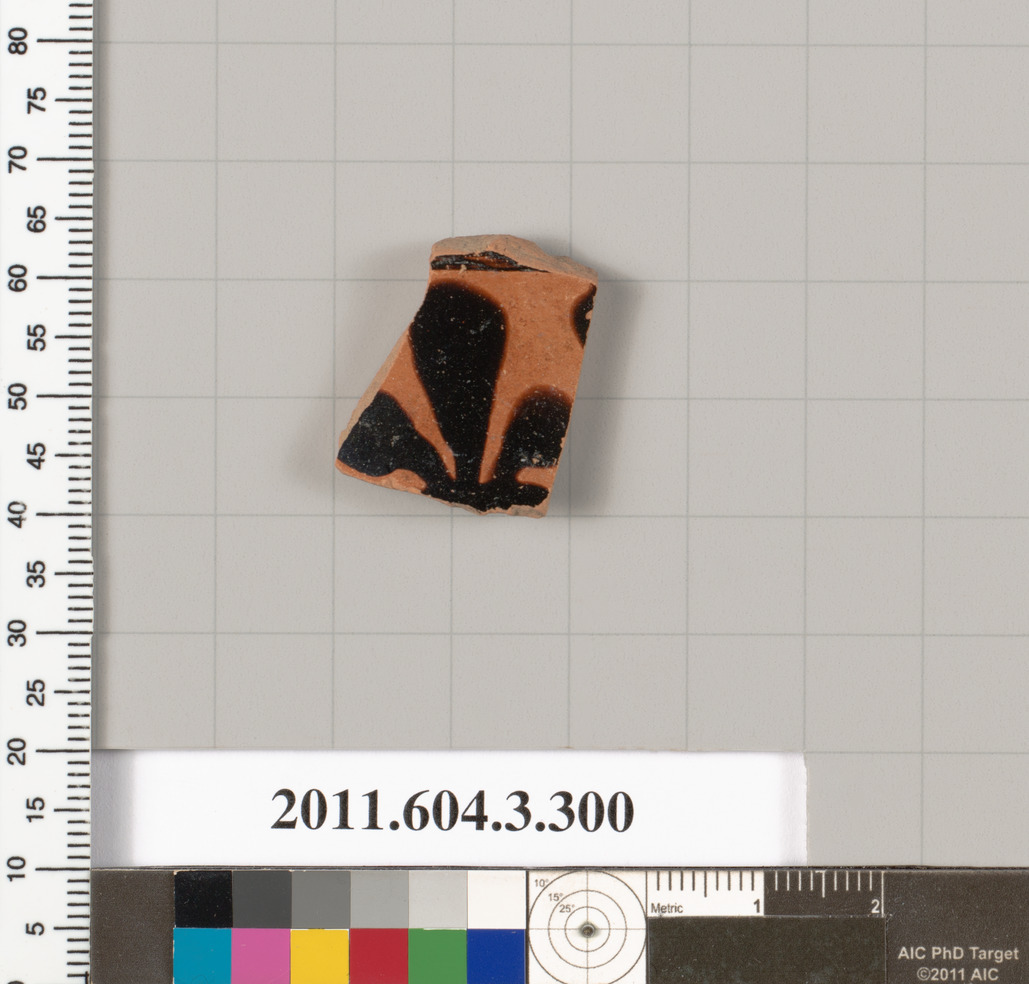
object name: neck amphora fragment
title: Terracotta fragment of a neck-amphora (jar)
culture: greek, attic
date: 534-468 BCE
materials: terracotta